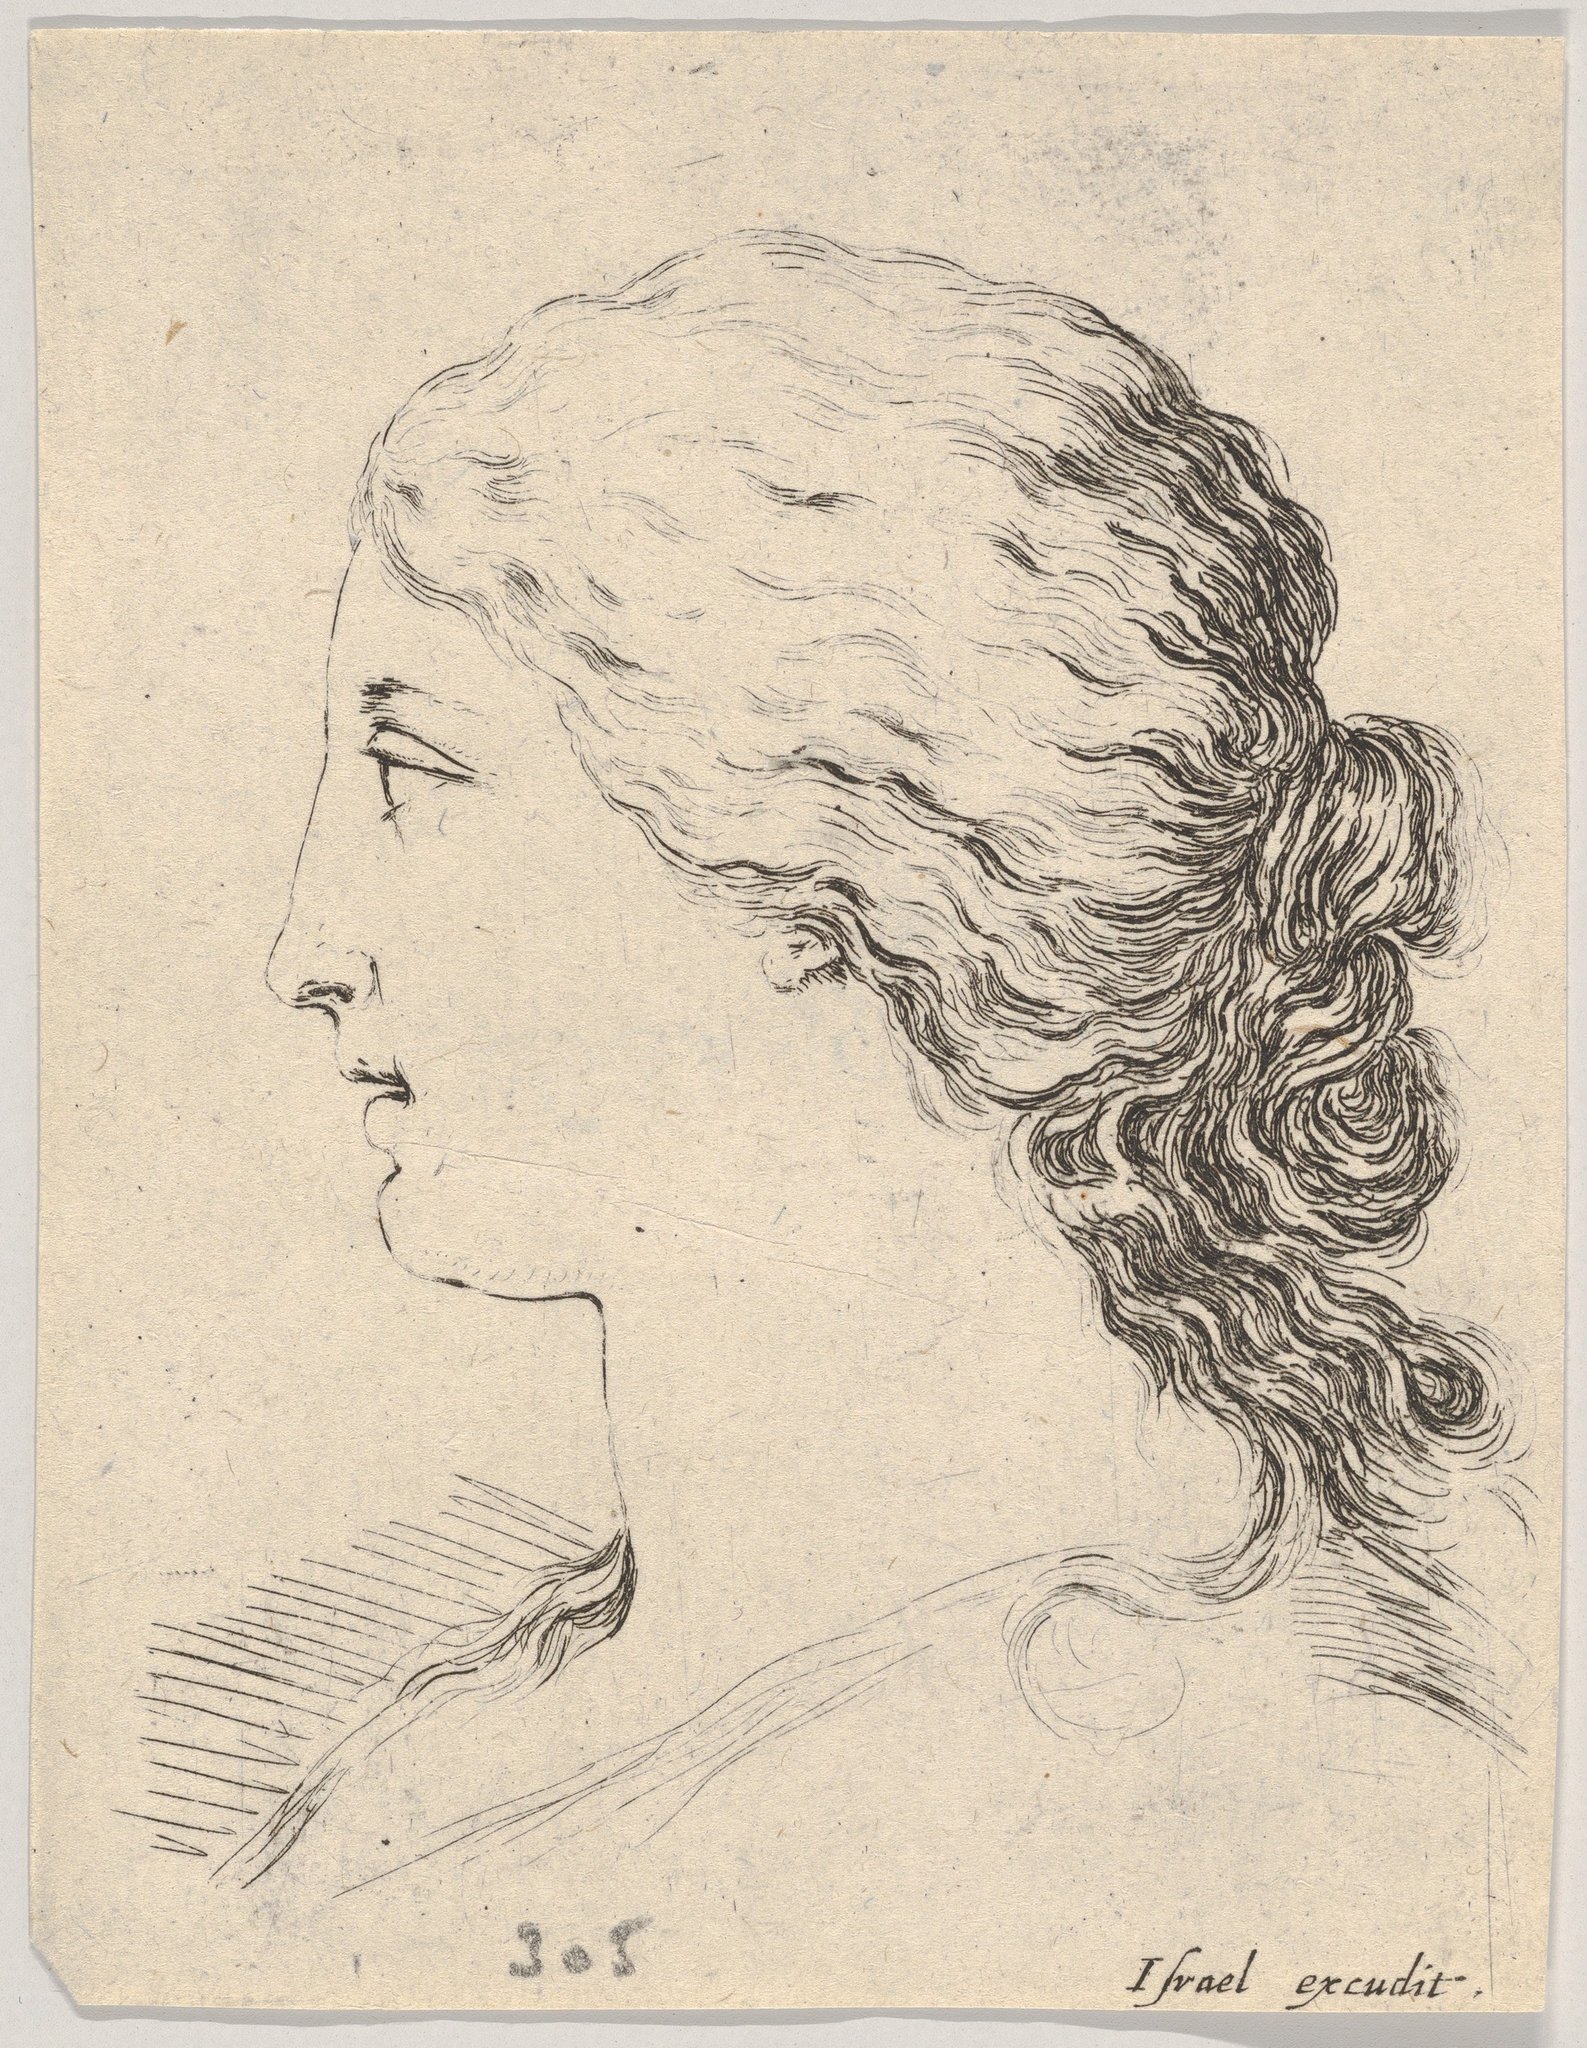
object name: print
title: Plate 14: Head of a woman, in profile, from "The Book for Learning to Draw" (Livre pour apprendre à dessiner)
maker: stefano della bella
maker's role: artist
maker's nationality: italian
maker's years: 1610-1664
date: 1649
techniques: etching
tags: heads,profiles,women